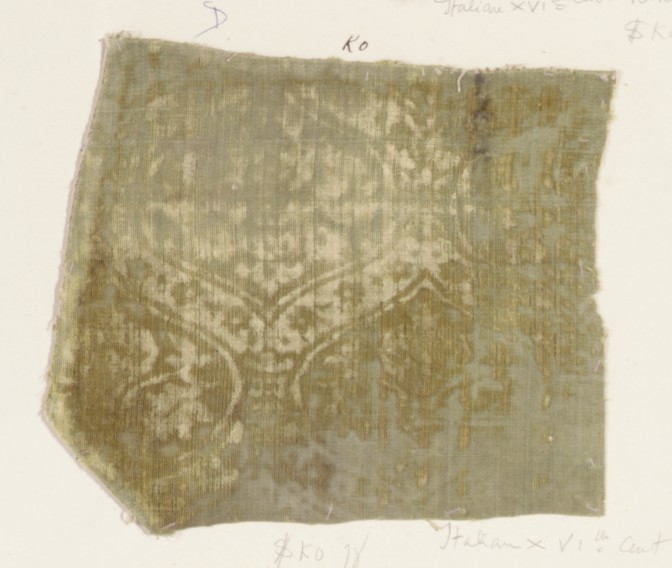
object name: fragment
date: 1567-1600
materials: silk